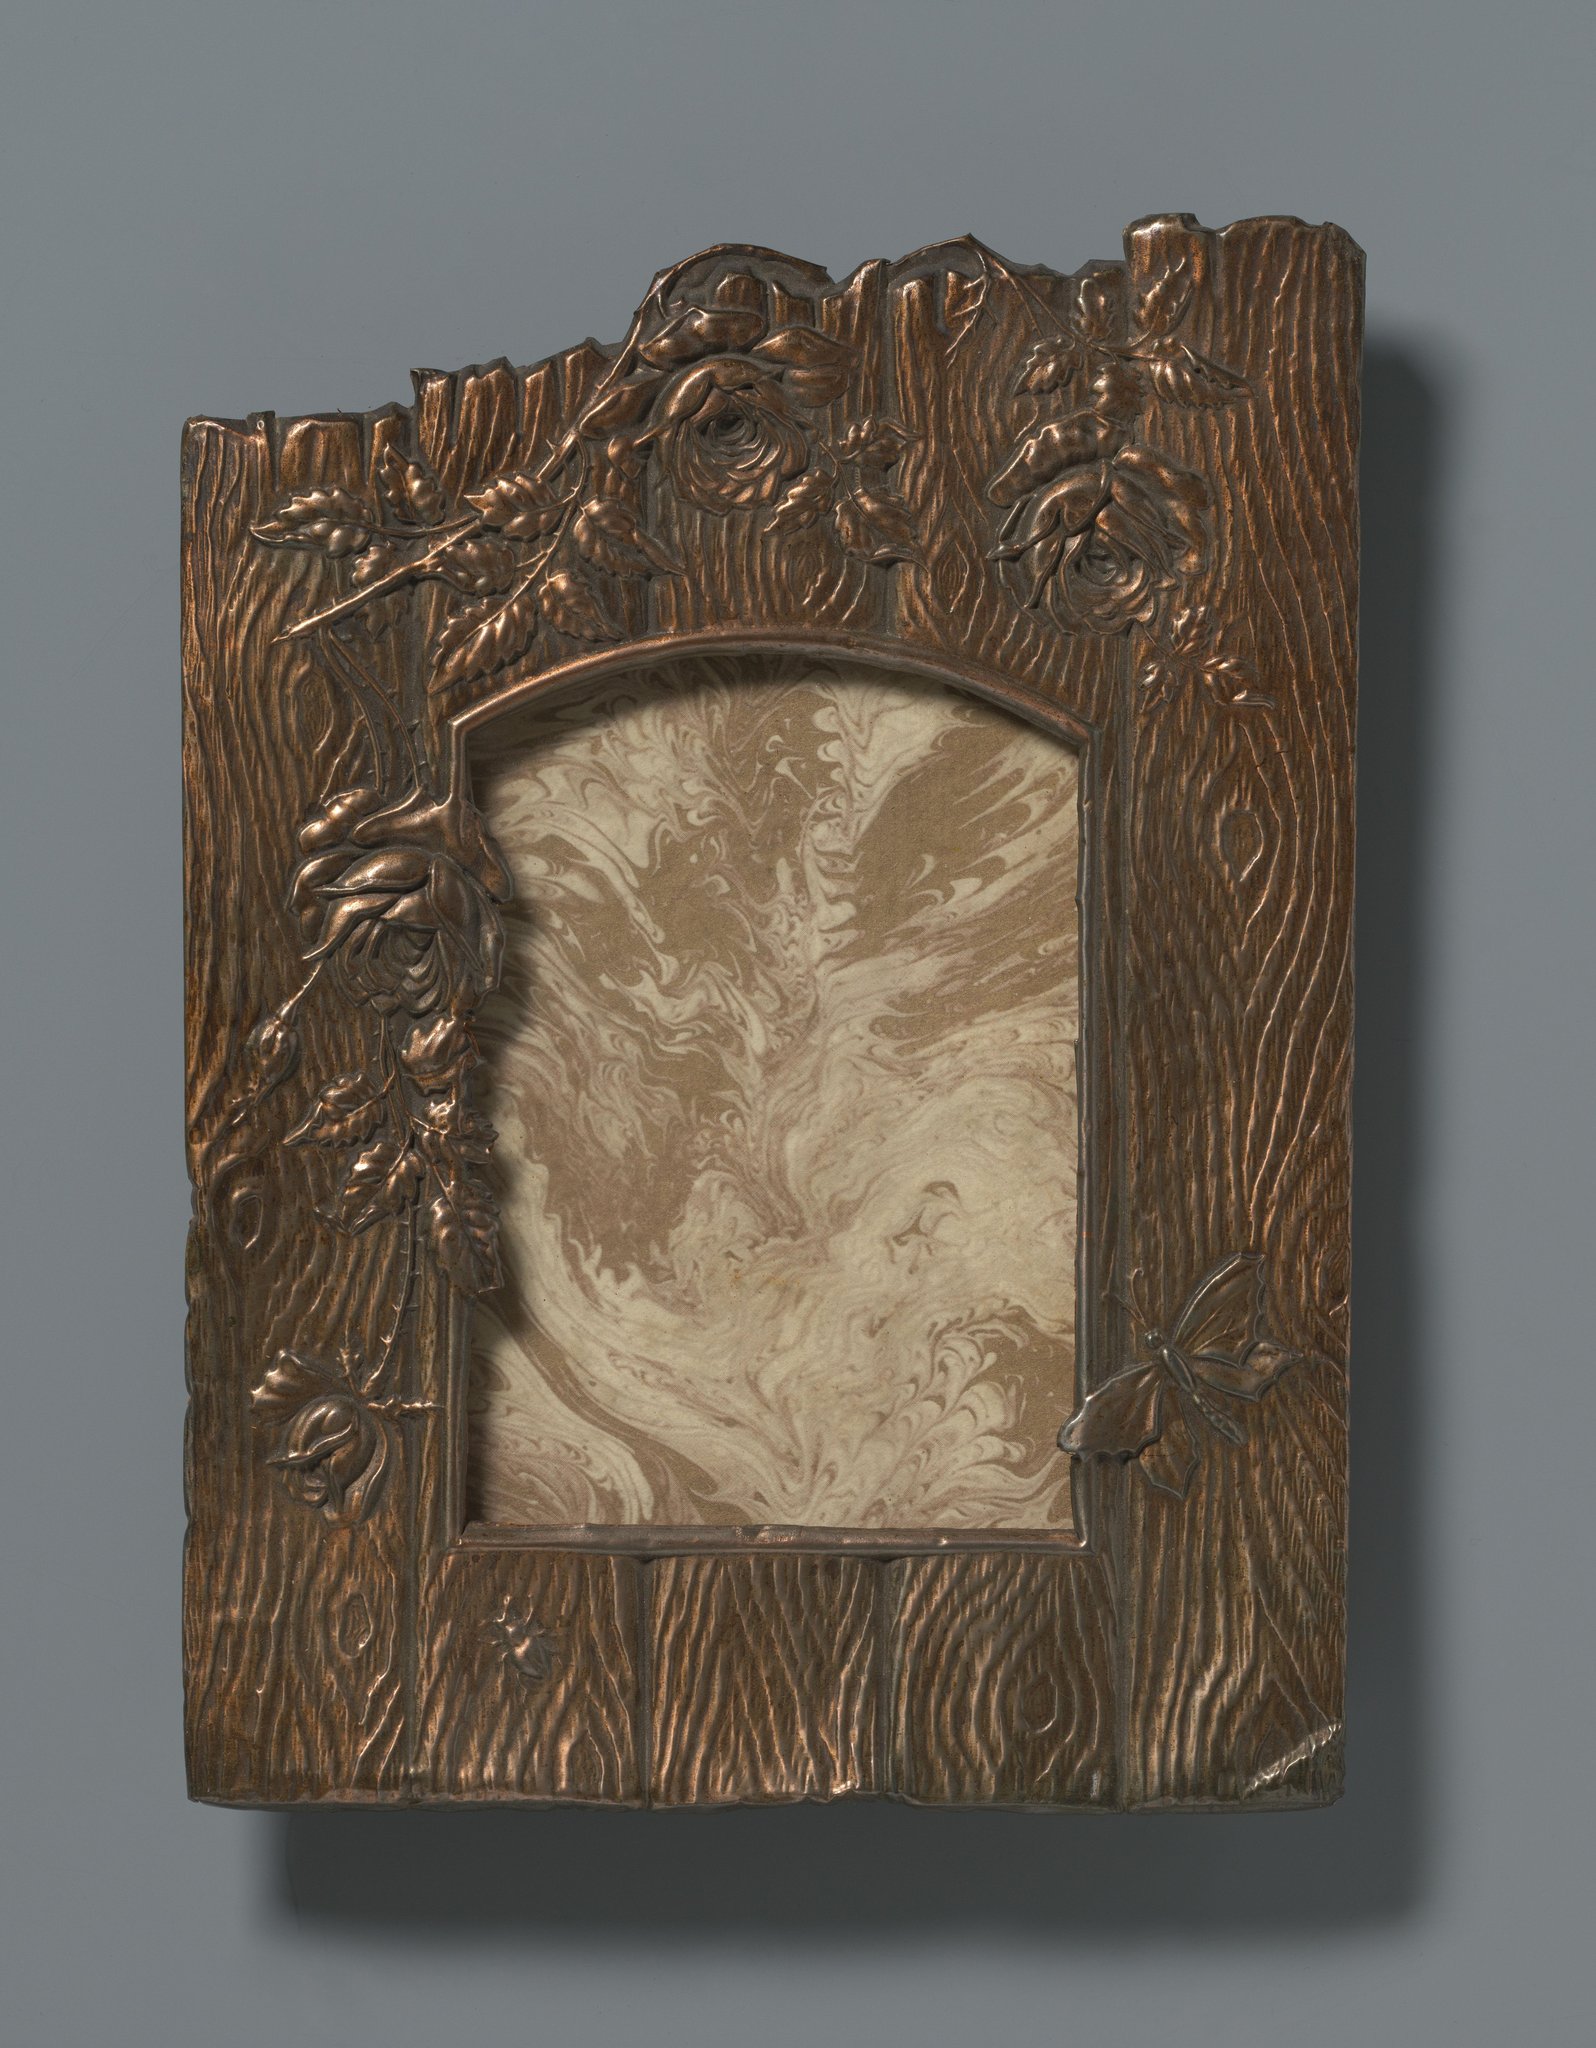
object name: frame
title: Fotolijst met rozen en houtstructuur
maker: Anonymous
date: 1881-1930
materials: cardboard, glass, linen, metal, paper, textile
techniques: autotype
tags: flowers: rose